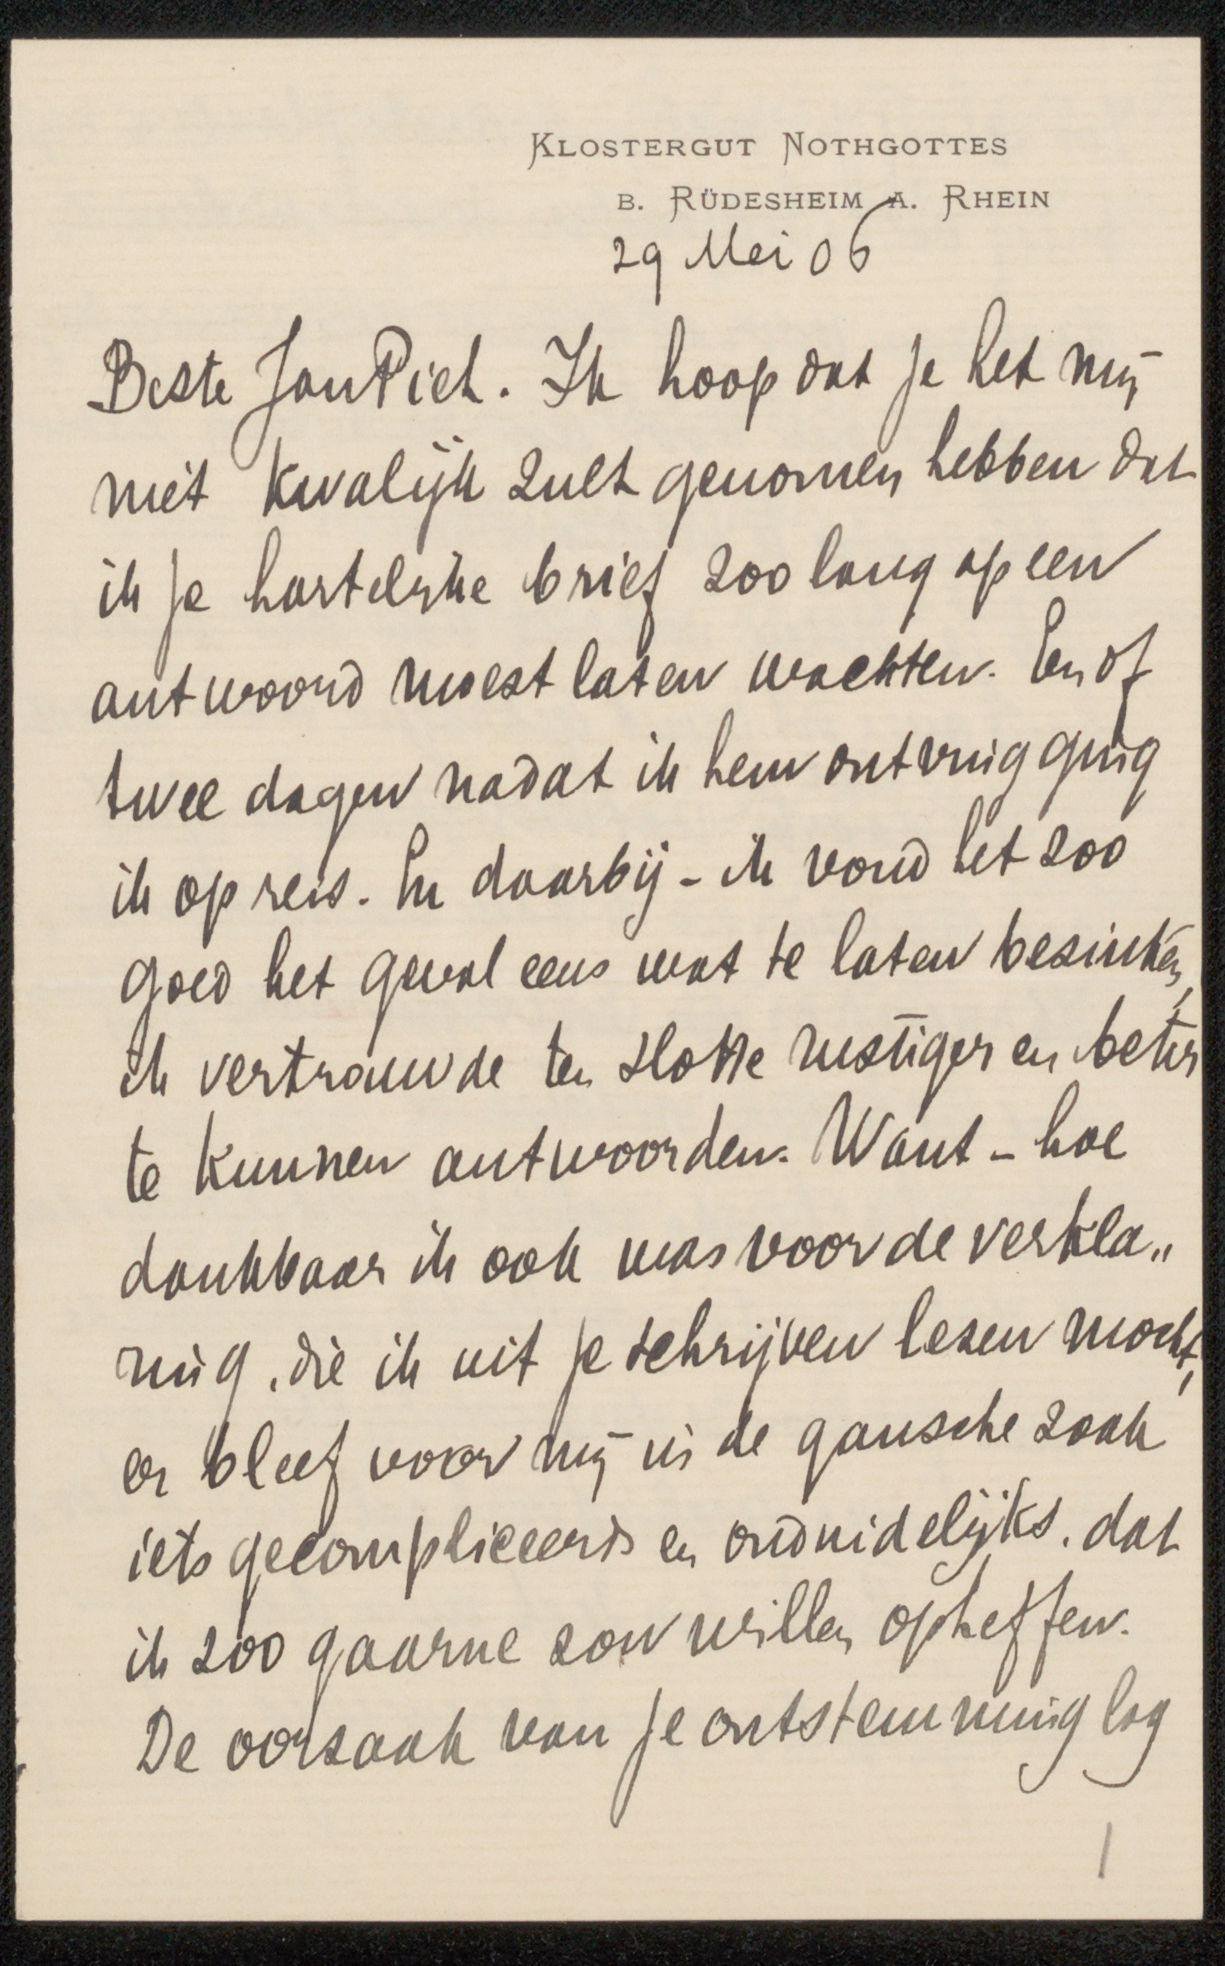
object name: letter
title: Brief aan Jan Veth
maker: antoon derkinderen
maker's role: draughtsman, painter, print maker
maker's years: 1859-1925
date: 1874-1925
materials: ink, paper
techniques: pen, printing, writing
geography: nothgottes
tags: dordrecht, designer, jan veth, amsterdam, print maker, draughtsman, pieter dupont, richard nicolaüs roland holst, the graphic arts, printed matter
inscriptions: collector's mark: ‘RPK’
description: Brief gedateerd 29 Mei 06 in latere hand.